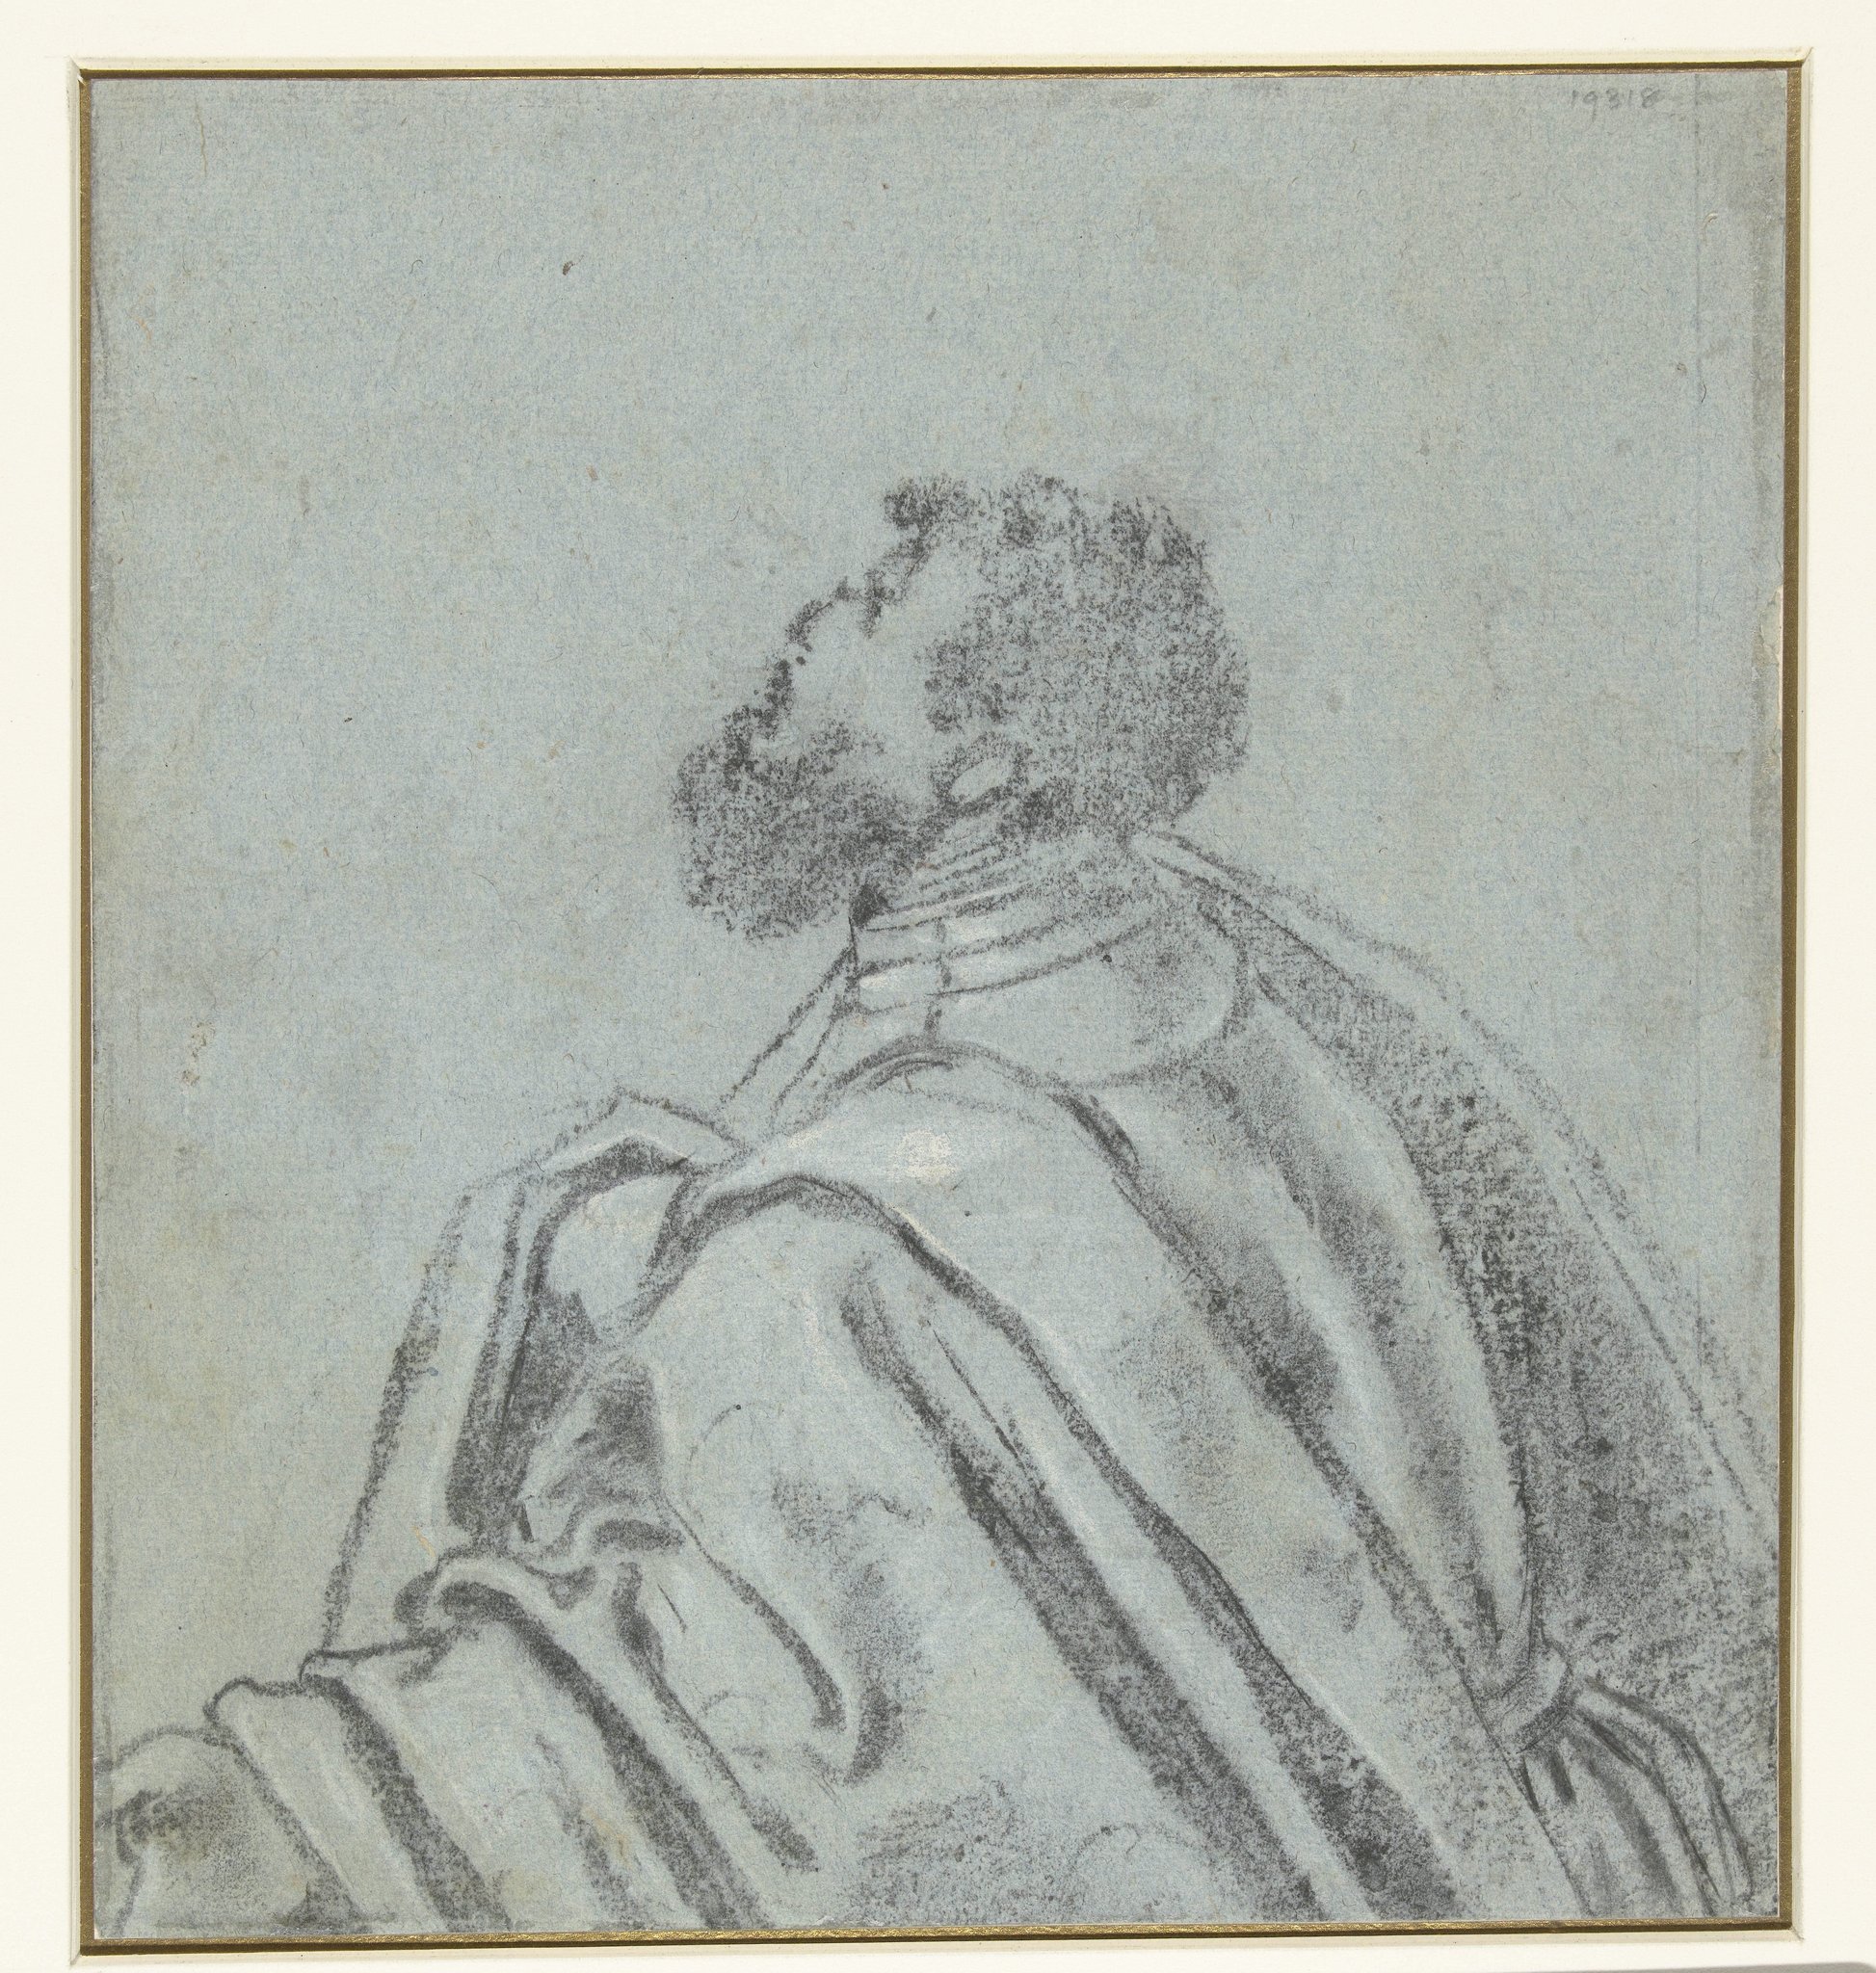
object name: drawing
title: Naar links opziende man, met gespreide armen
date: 1588-1660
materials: chalk, paper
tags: male sex; man